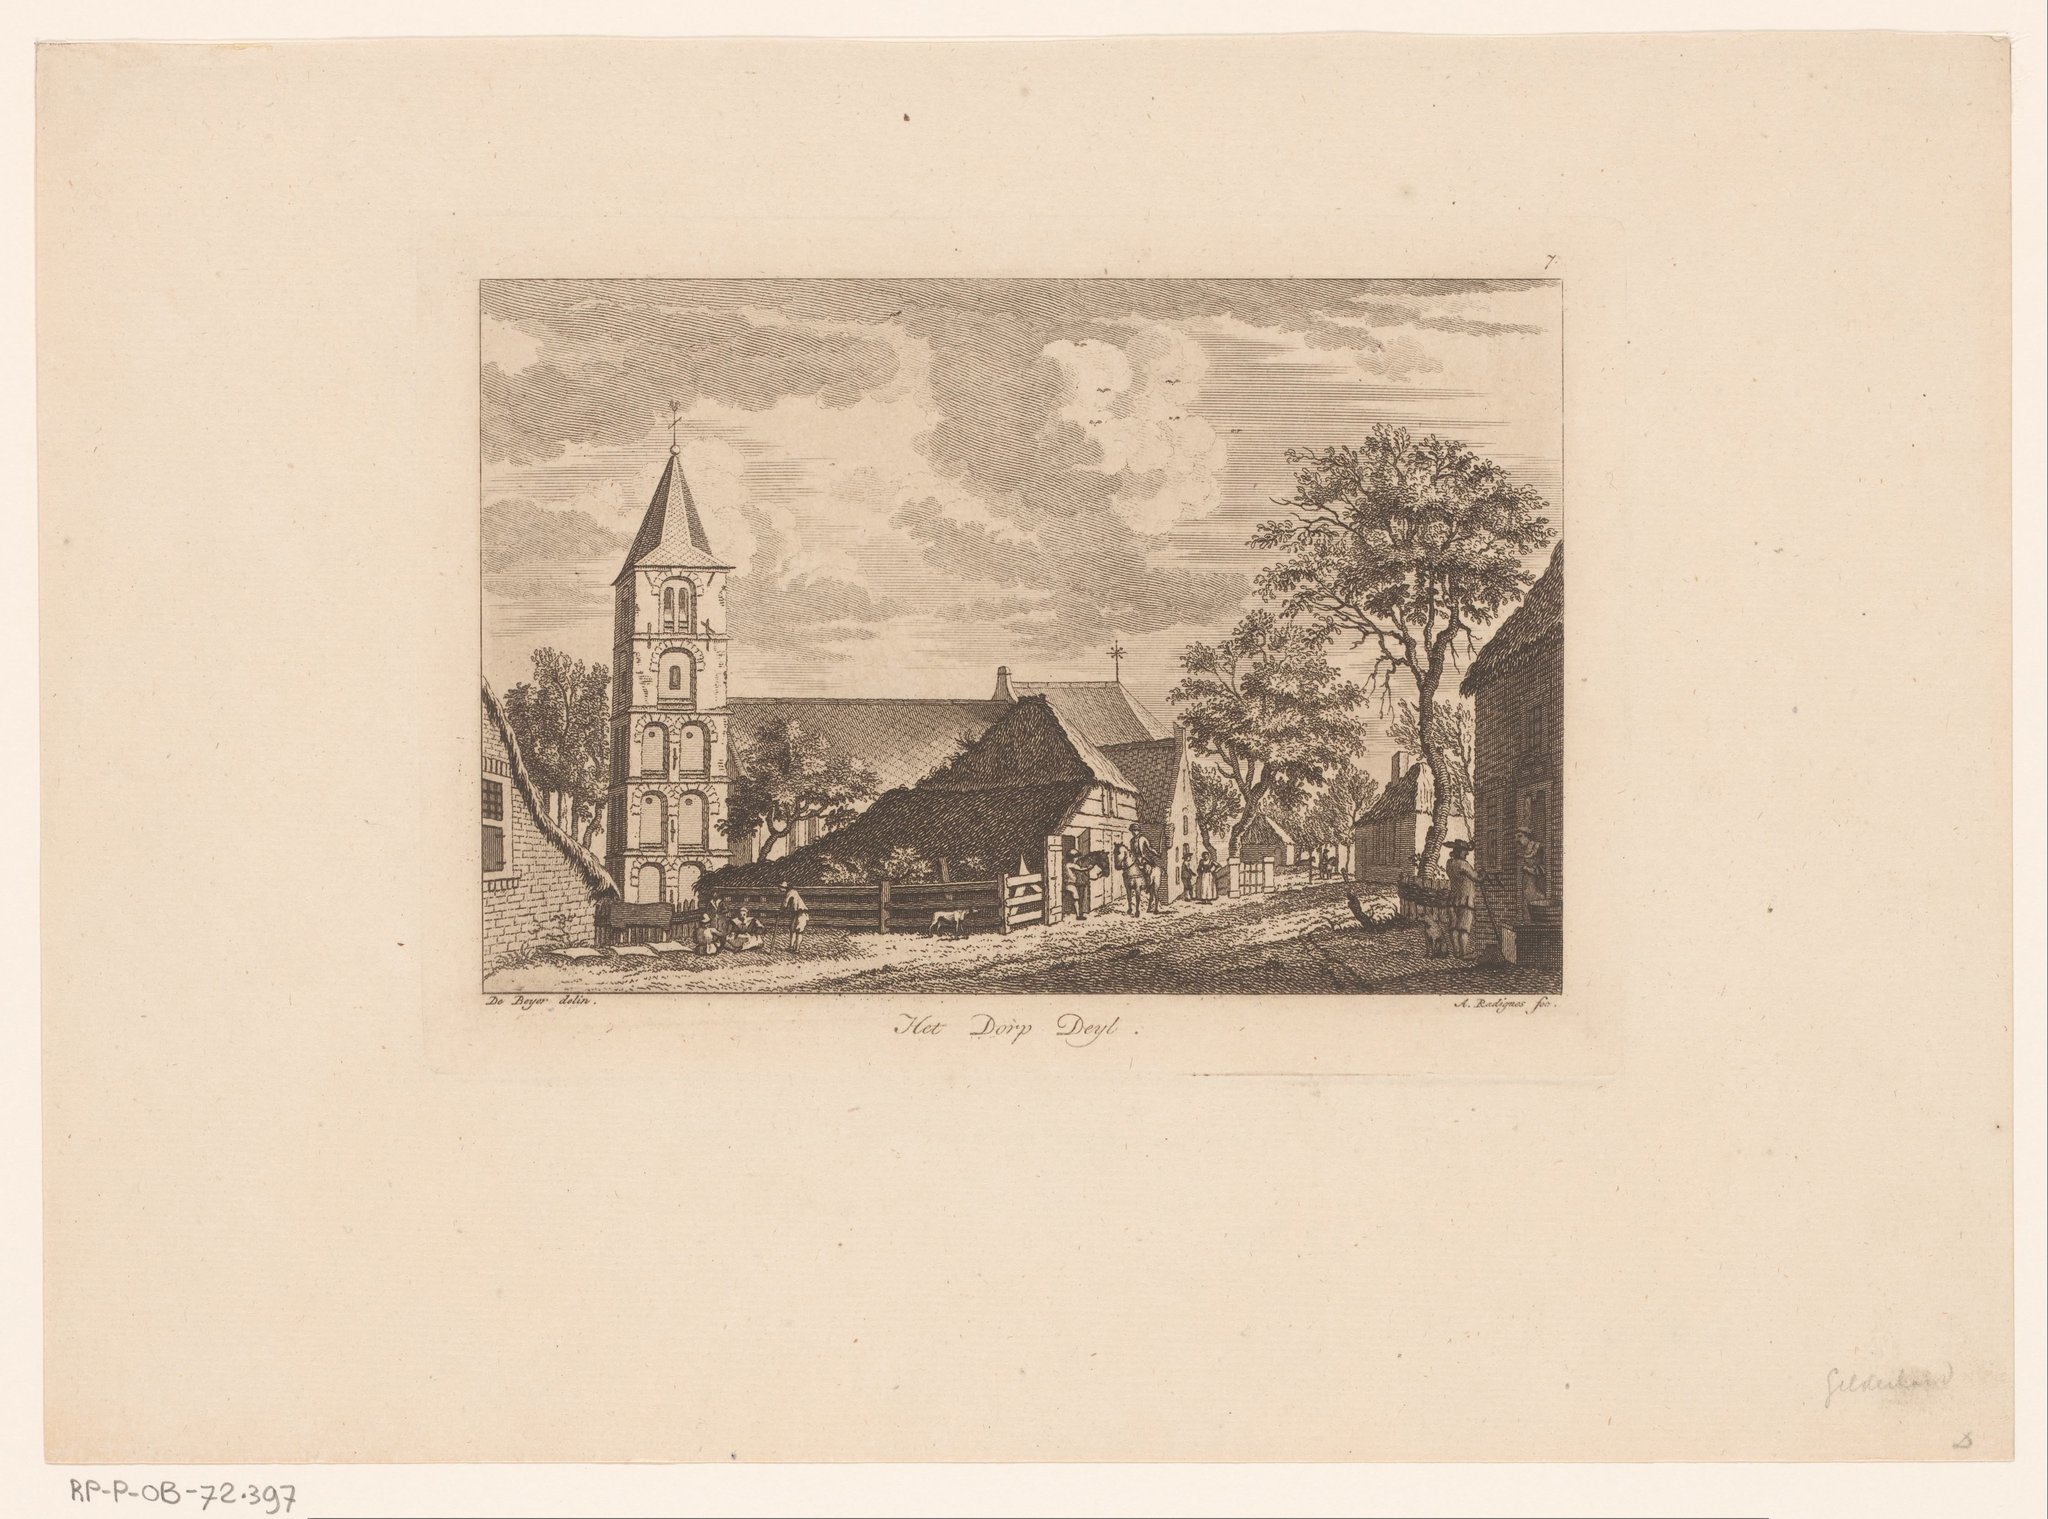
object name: print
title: Het dorp Deyl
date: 1731-1809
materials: paper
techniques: engraving, etching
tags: prospect of village, silhouette of village, church (exterior)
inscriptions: collector's mark: Lugt 2228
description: Gezicht op het dorp Deil, met links de toren van de hervormde kerk.